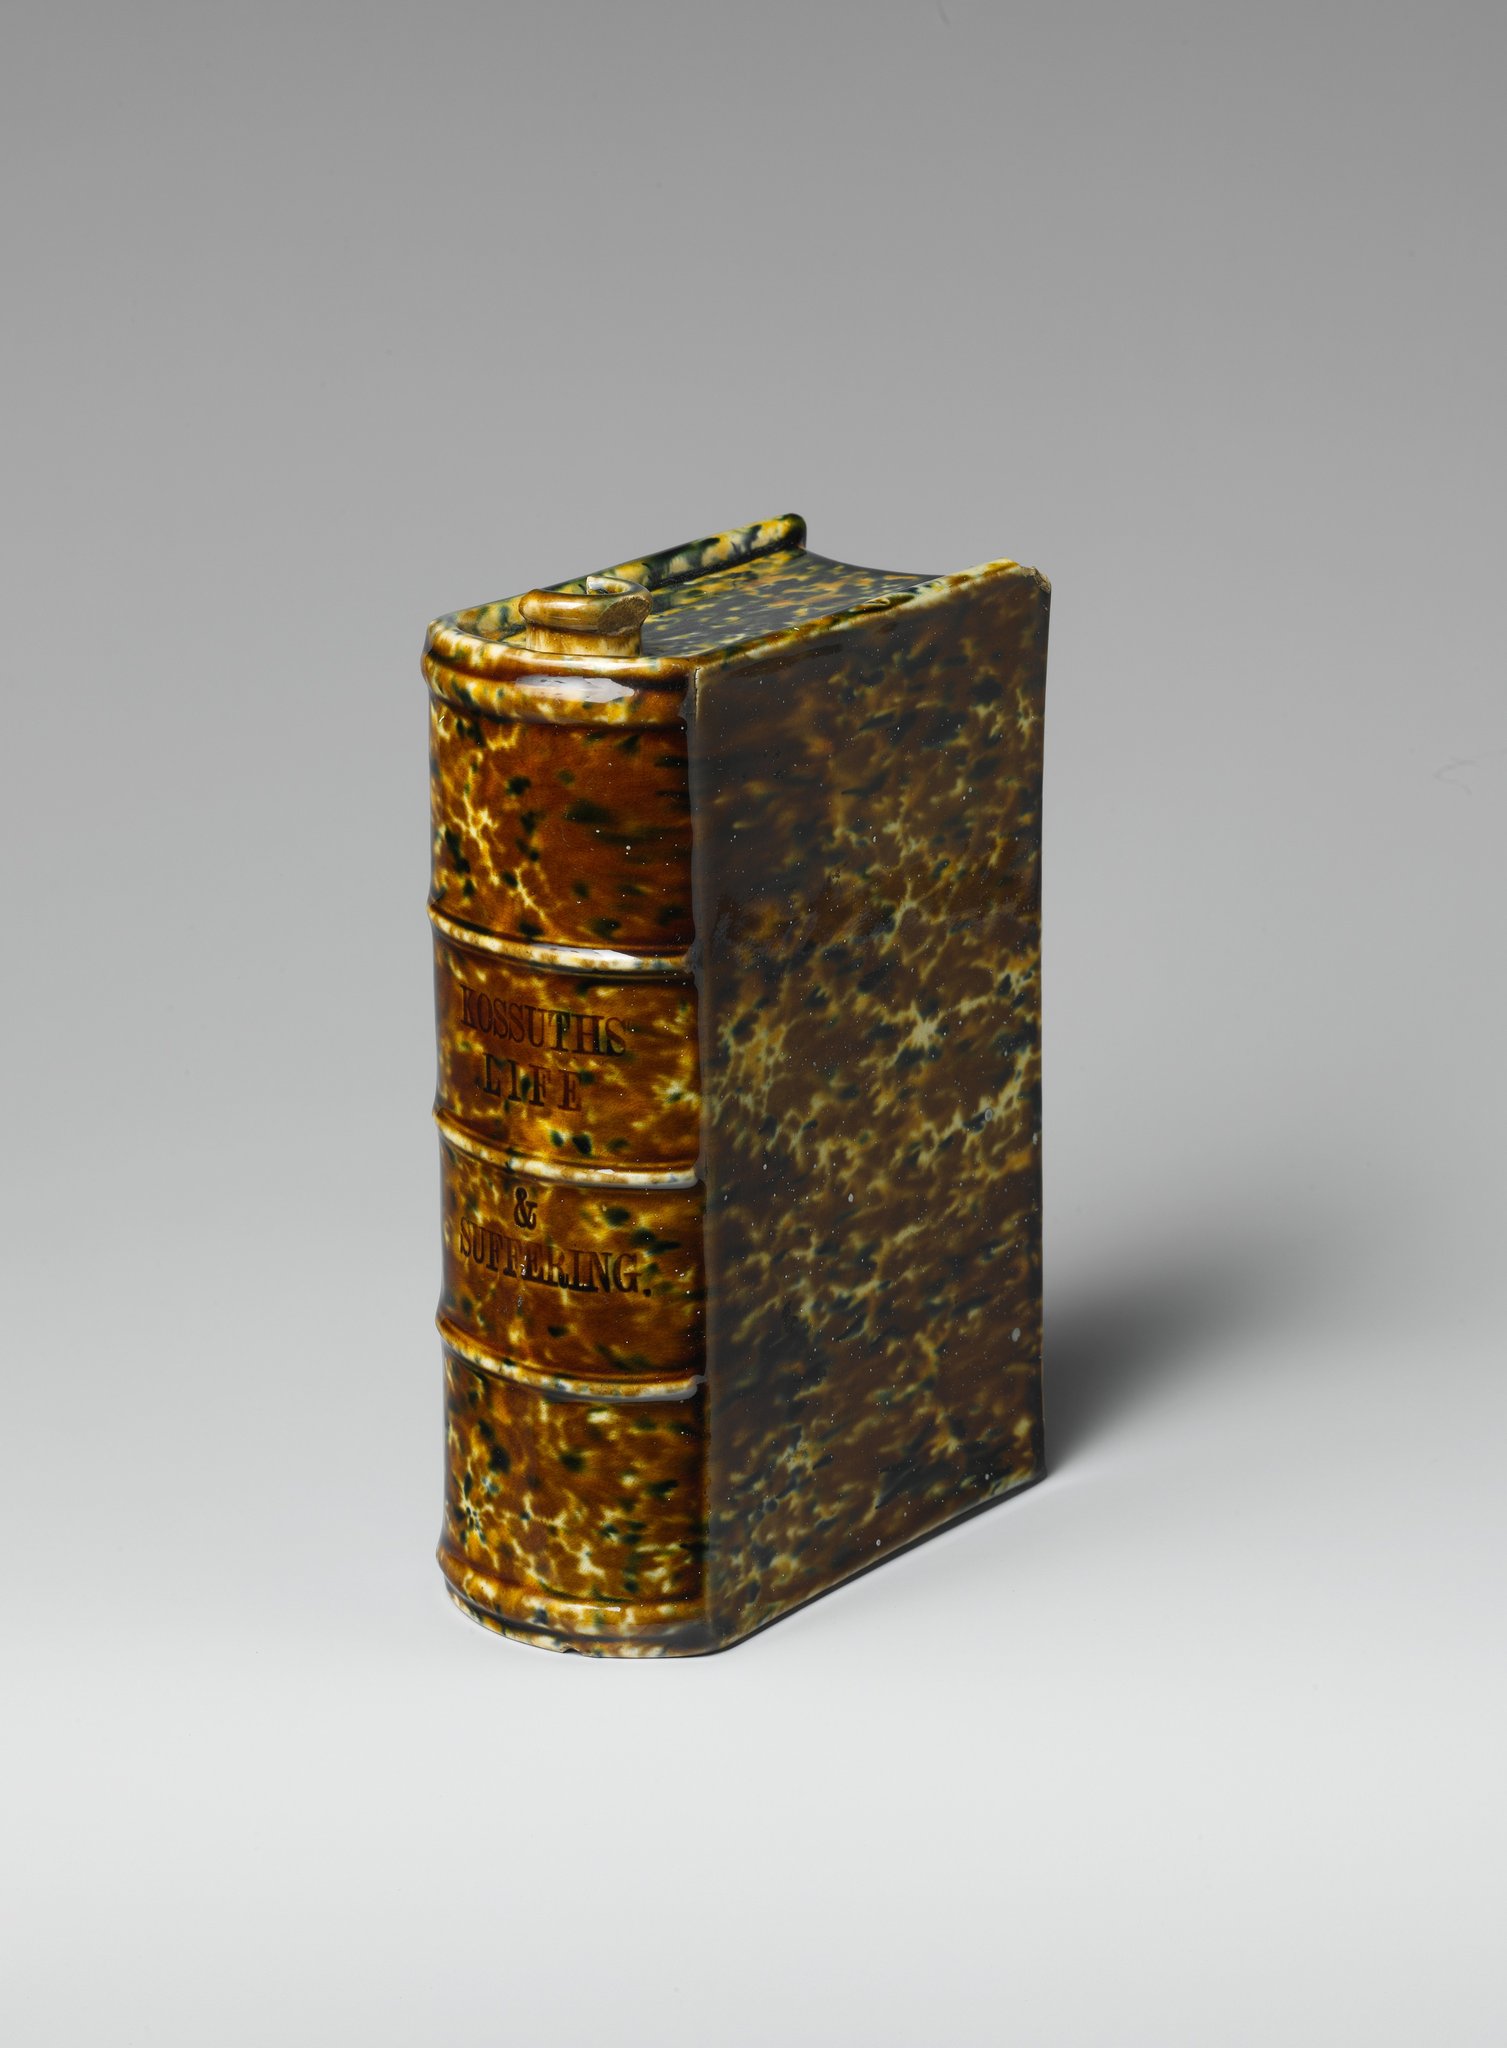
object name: flask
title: Book flask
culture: american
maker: united states pottery company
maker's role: maker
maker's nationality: american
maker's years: 1852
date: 1849-1858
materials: earthenware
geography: united states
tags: books